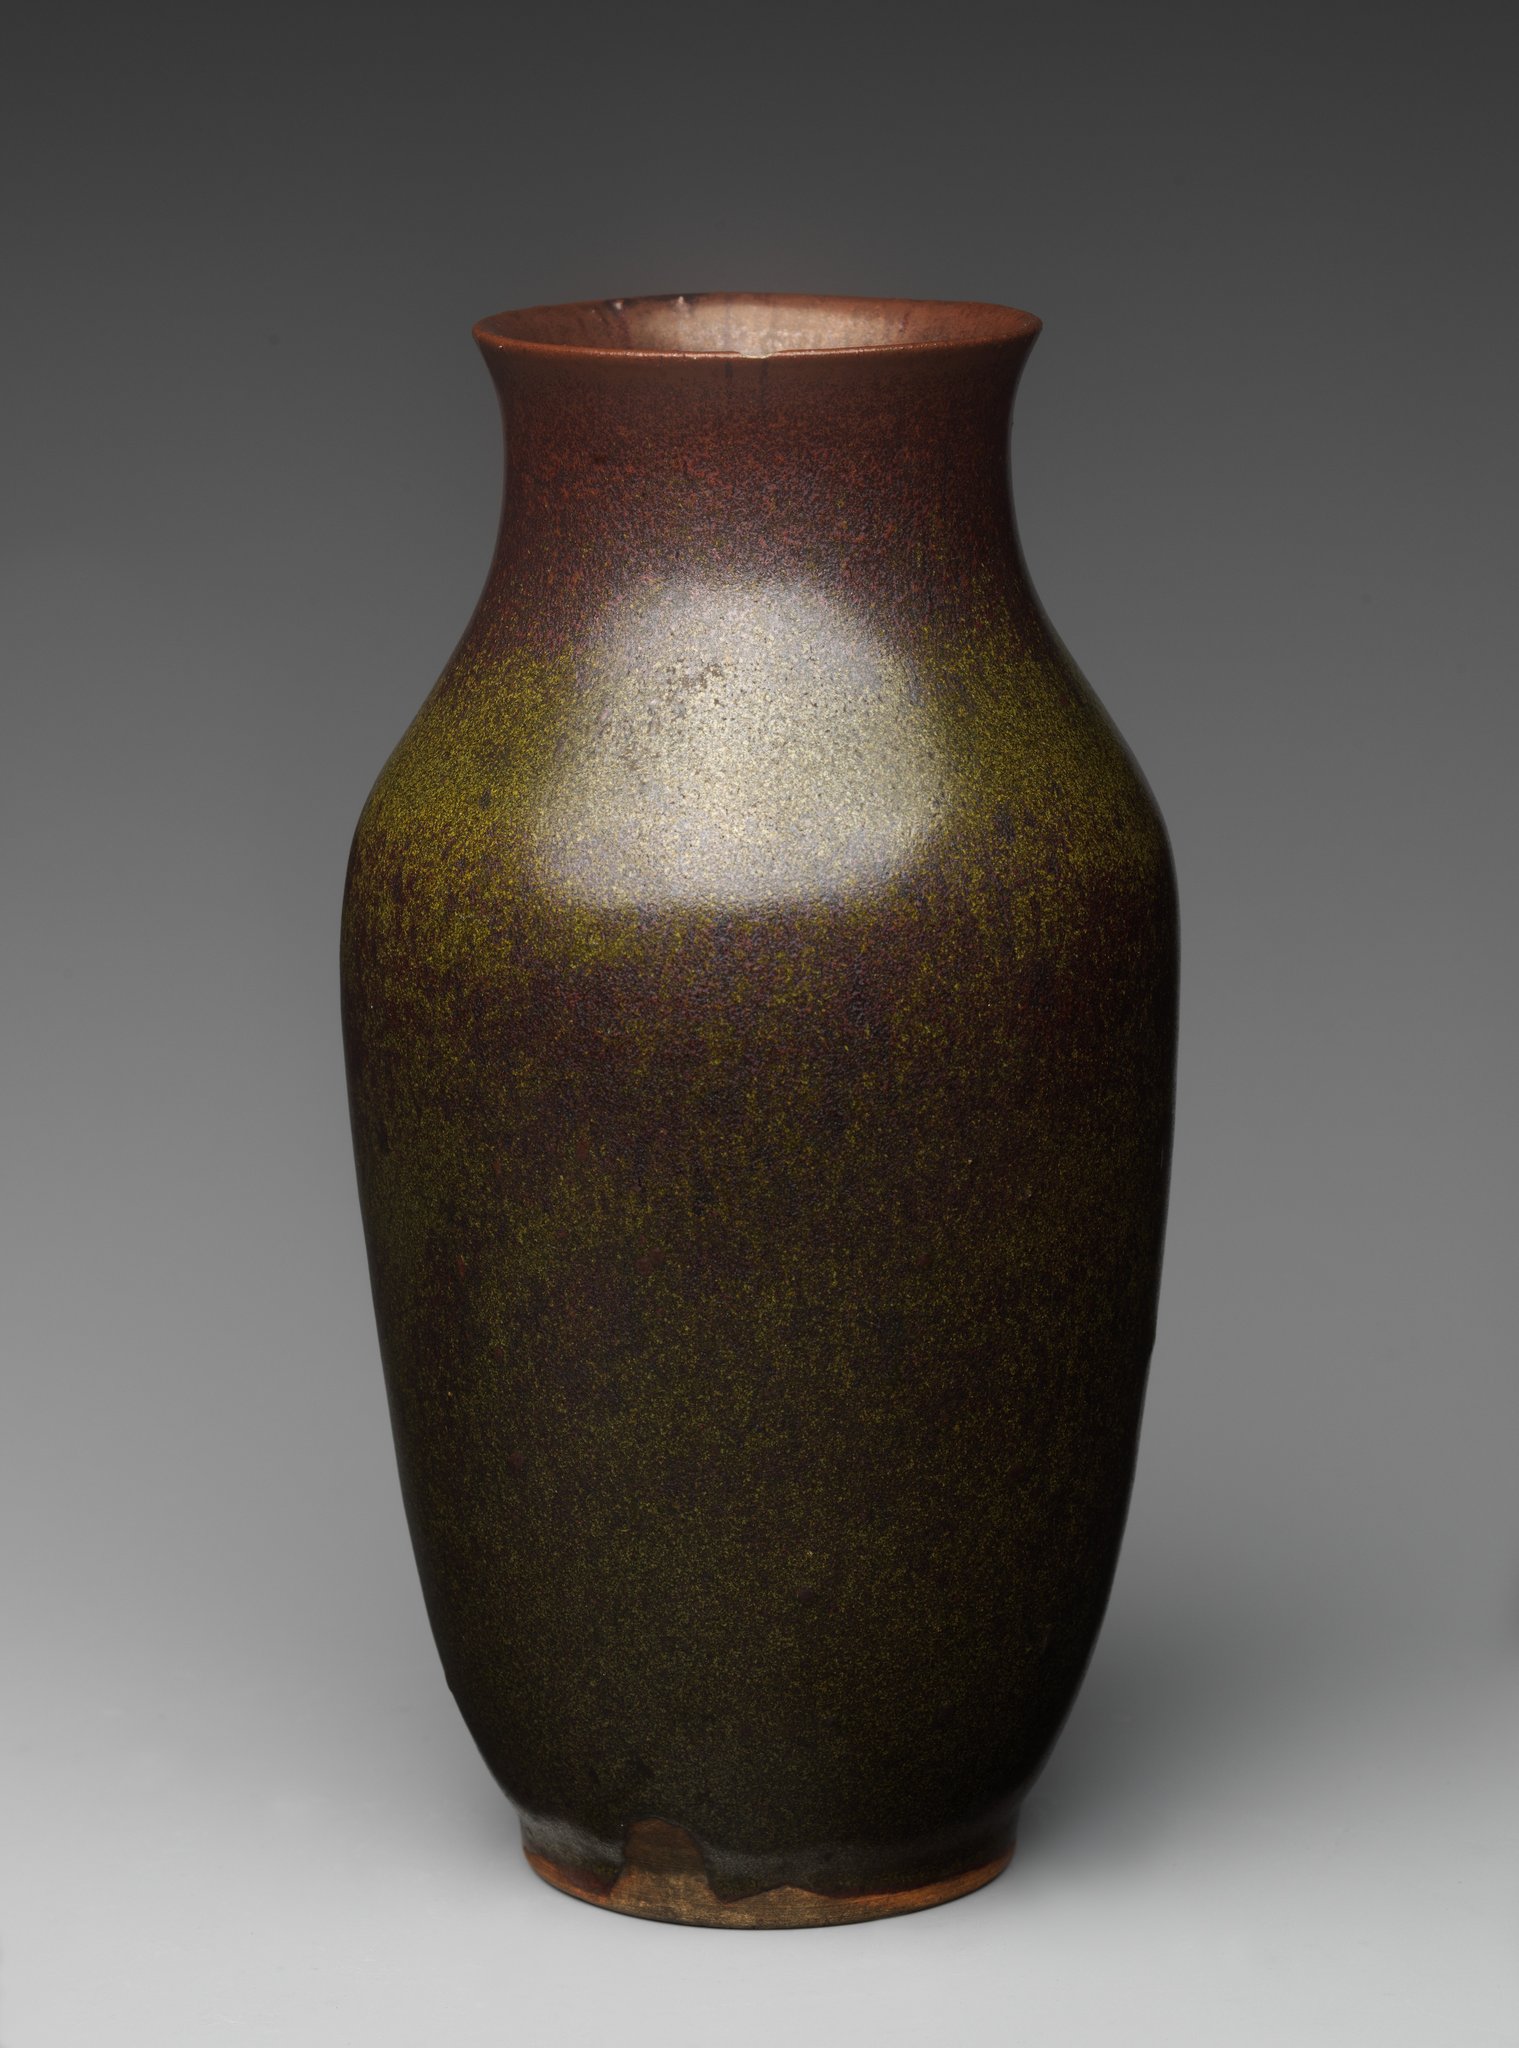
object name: vase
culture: japanese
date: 1701-1800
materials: clay, glaze